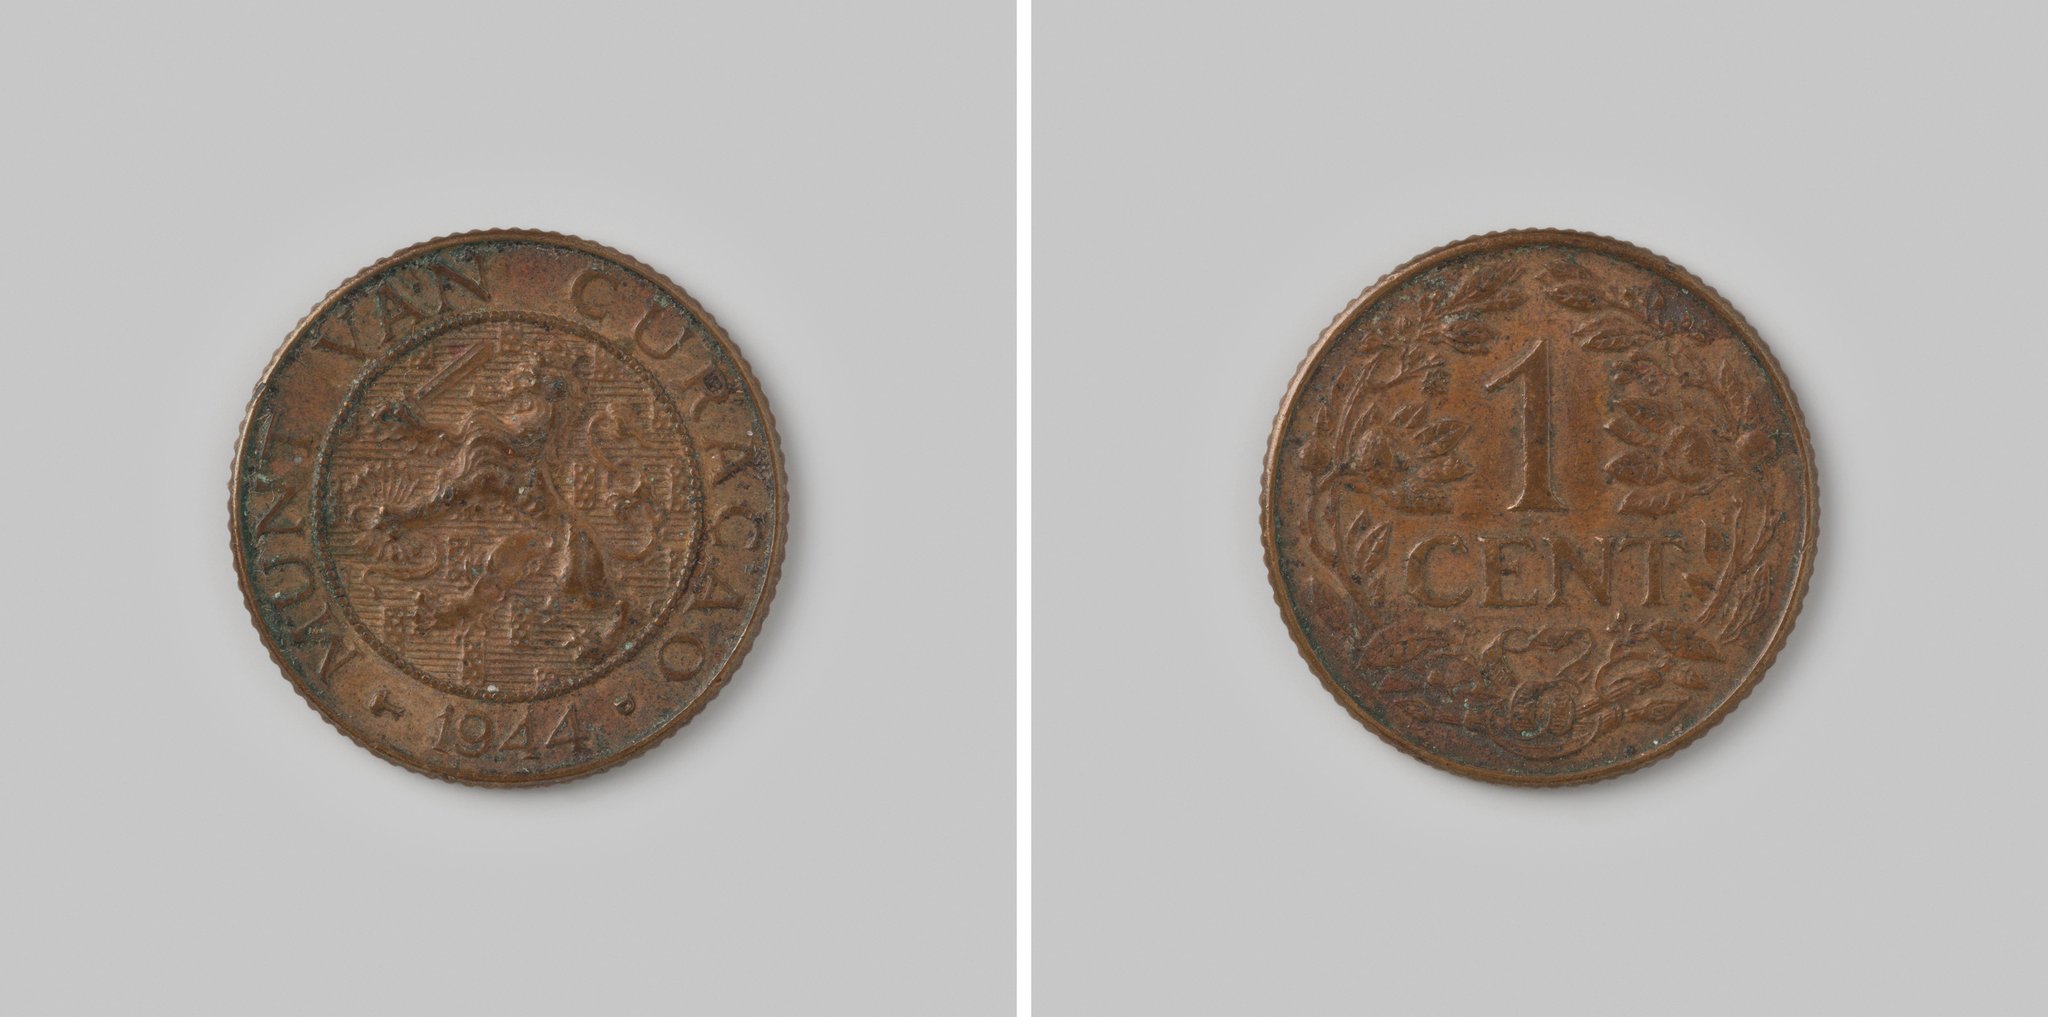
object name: coin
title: Cent van Curaçao, 1944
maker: wilhelmina of the netherlands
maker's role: print maker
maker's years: 1880-1962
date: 1944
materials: bronze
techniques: striking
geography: denver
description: Bronzen munt. Voorzijde: in een veld wapen van Nederland. Omschrift: munt van Curaçao. Onderaan in omschrift tussen palmboom en letter D [=Denver] jaartal. Keerzijde: binnen twee samengebonden oranjetakken waarde-aanduiding 1 cent. Kartelrand.